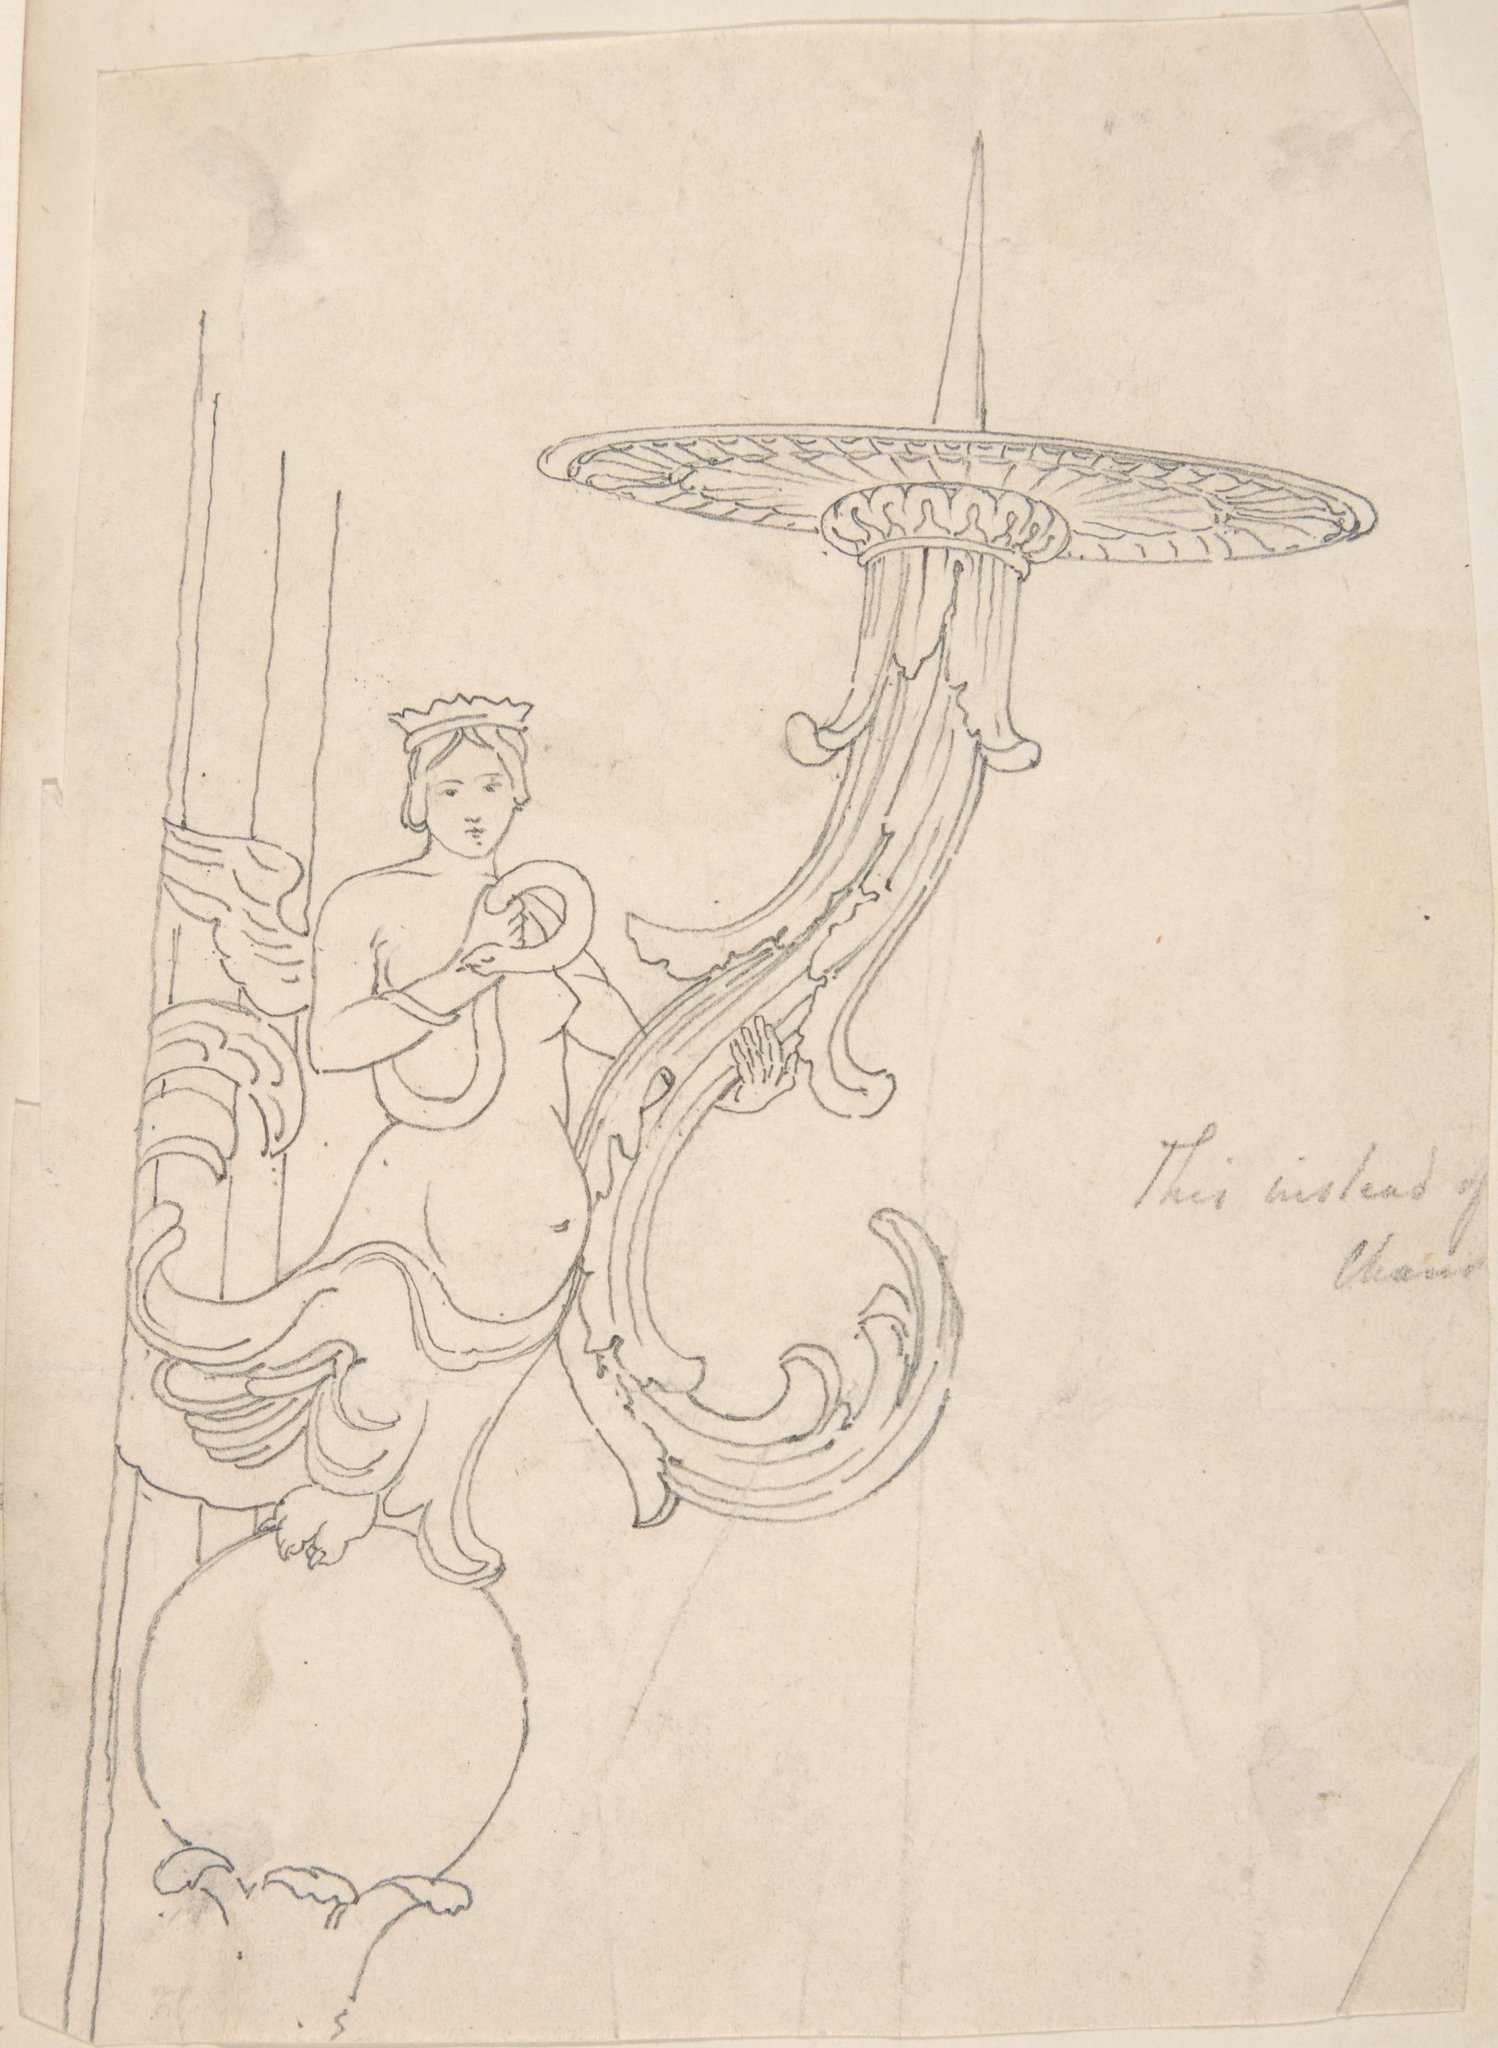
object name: drawing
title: Design for Metal Candleholder Supported by a Sphinx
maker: anonymous, british, 19th century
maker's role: artist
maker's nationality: british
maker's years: 1800-1900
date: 1851-1900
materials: graphite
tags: sphinx